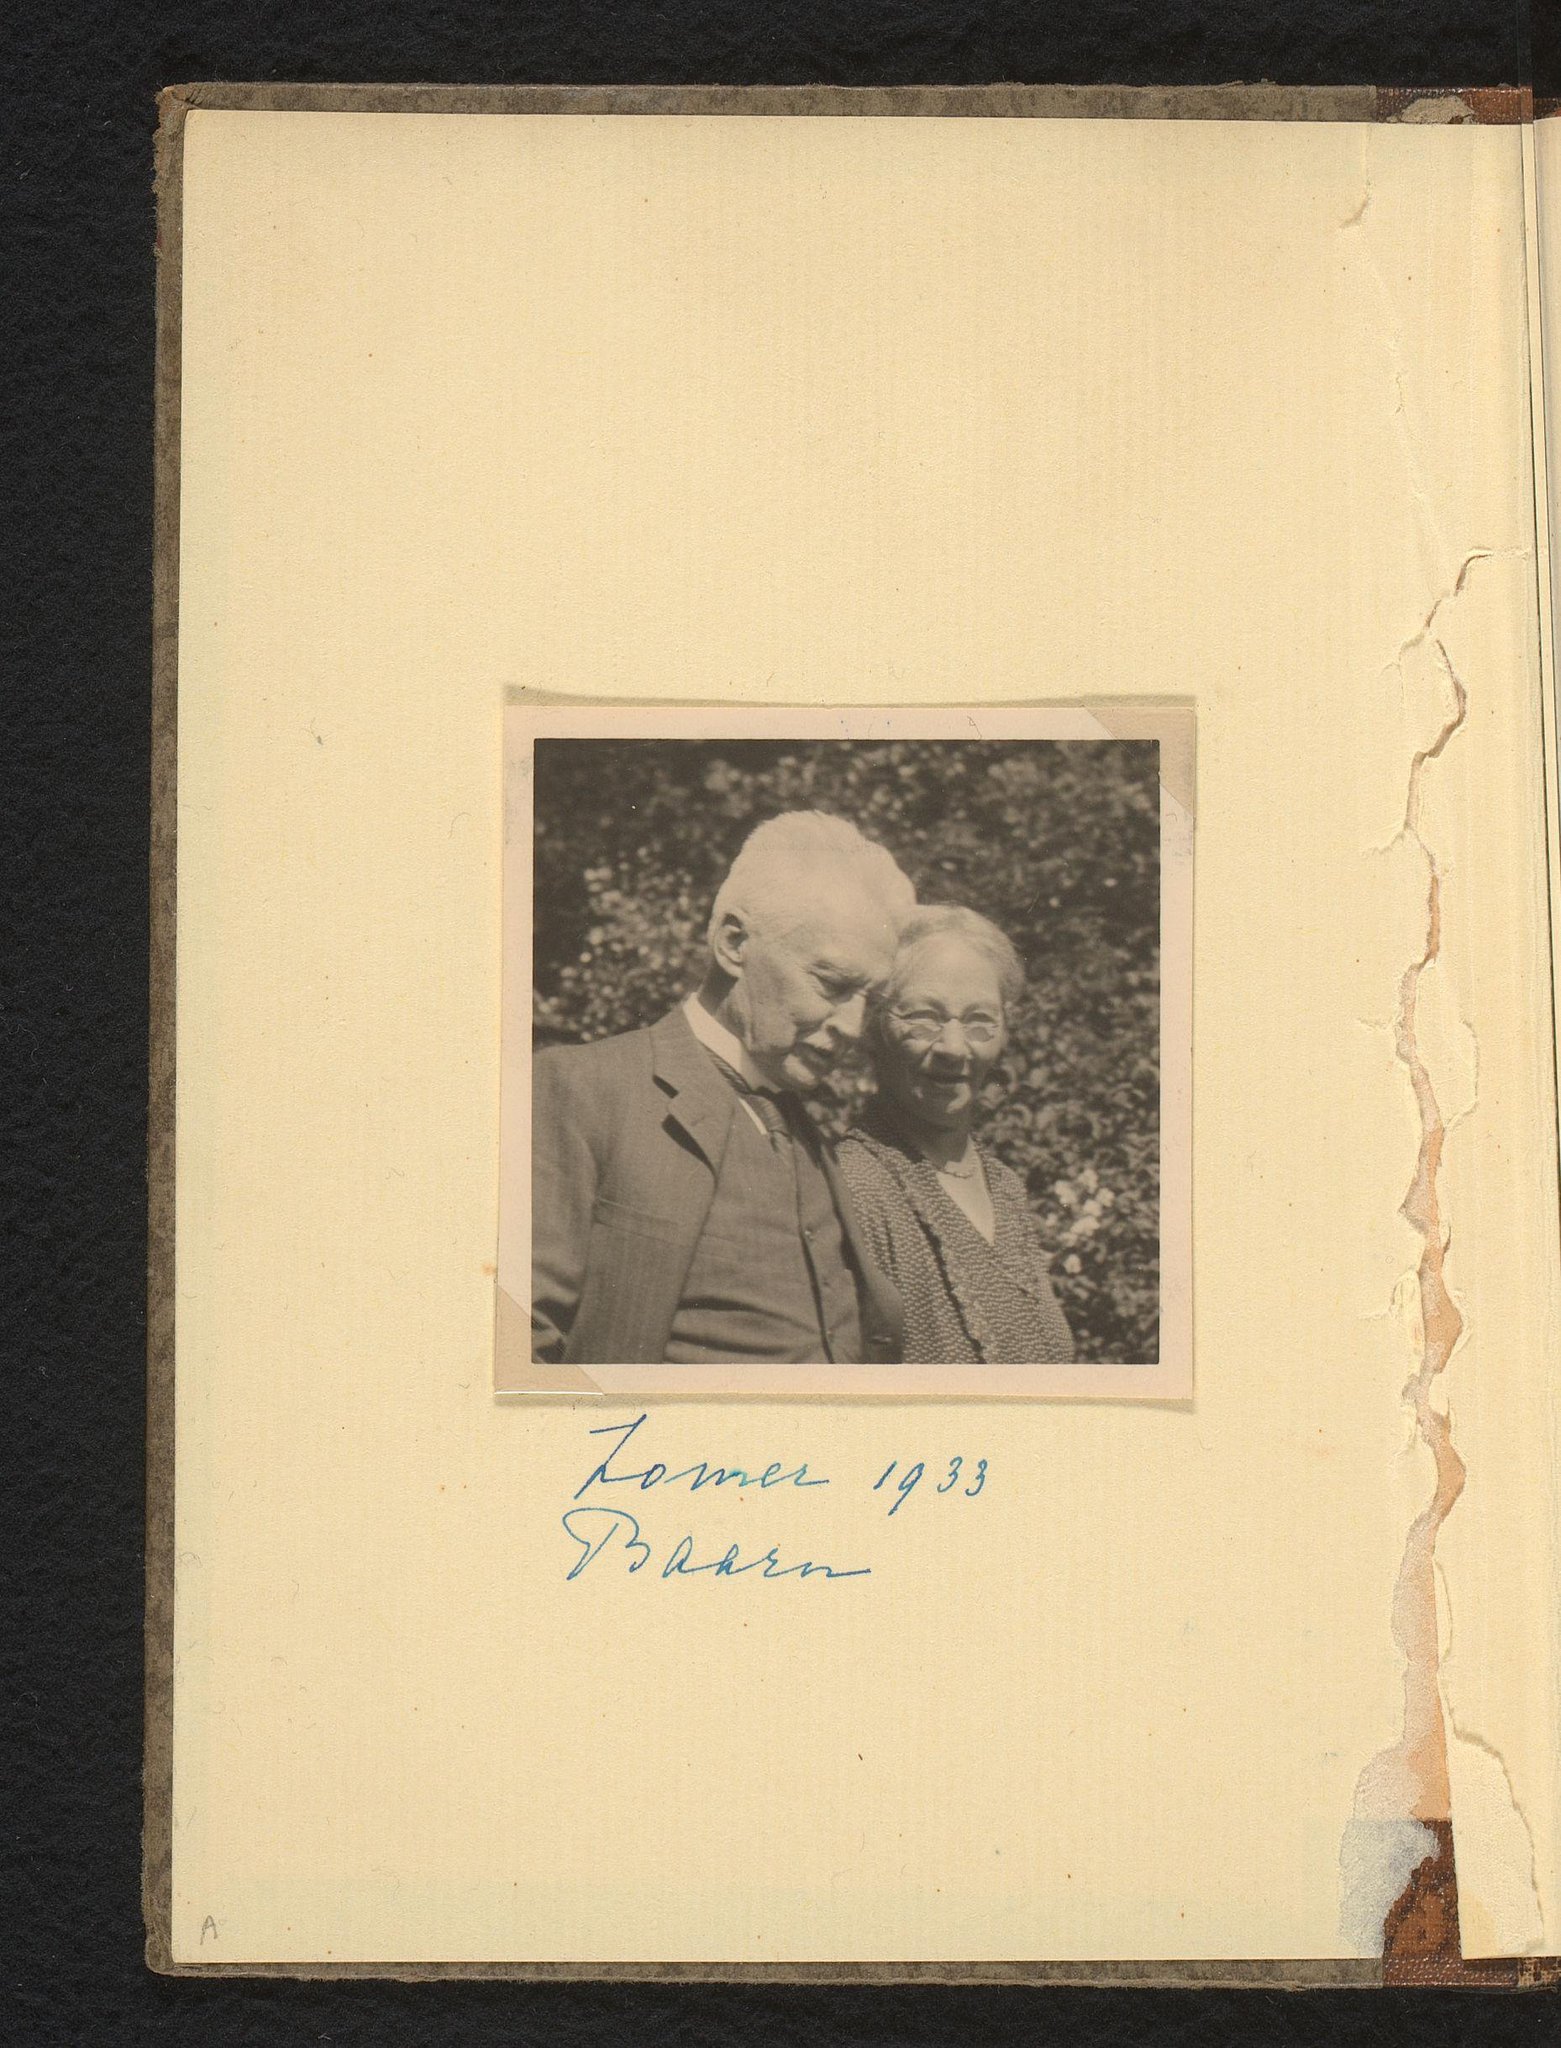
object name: photograph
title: Zomer 1933 Baarn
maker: Anonymous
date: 1933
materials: paper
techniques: gelatin silver print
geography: baarn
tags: couple of lovers, historical persons not known by name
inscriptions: inscription: ‘Zomer 1933/ Baarn’